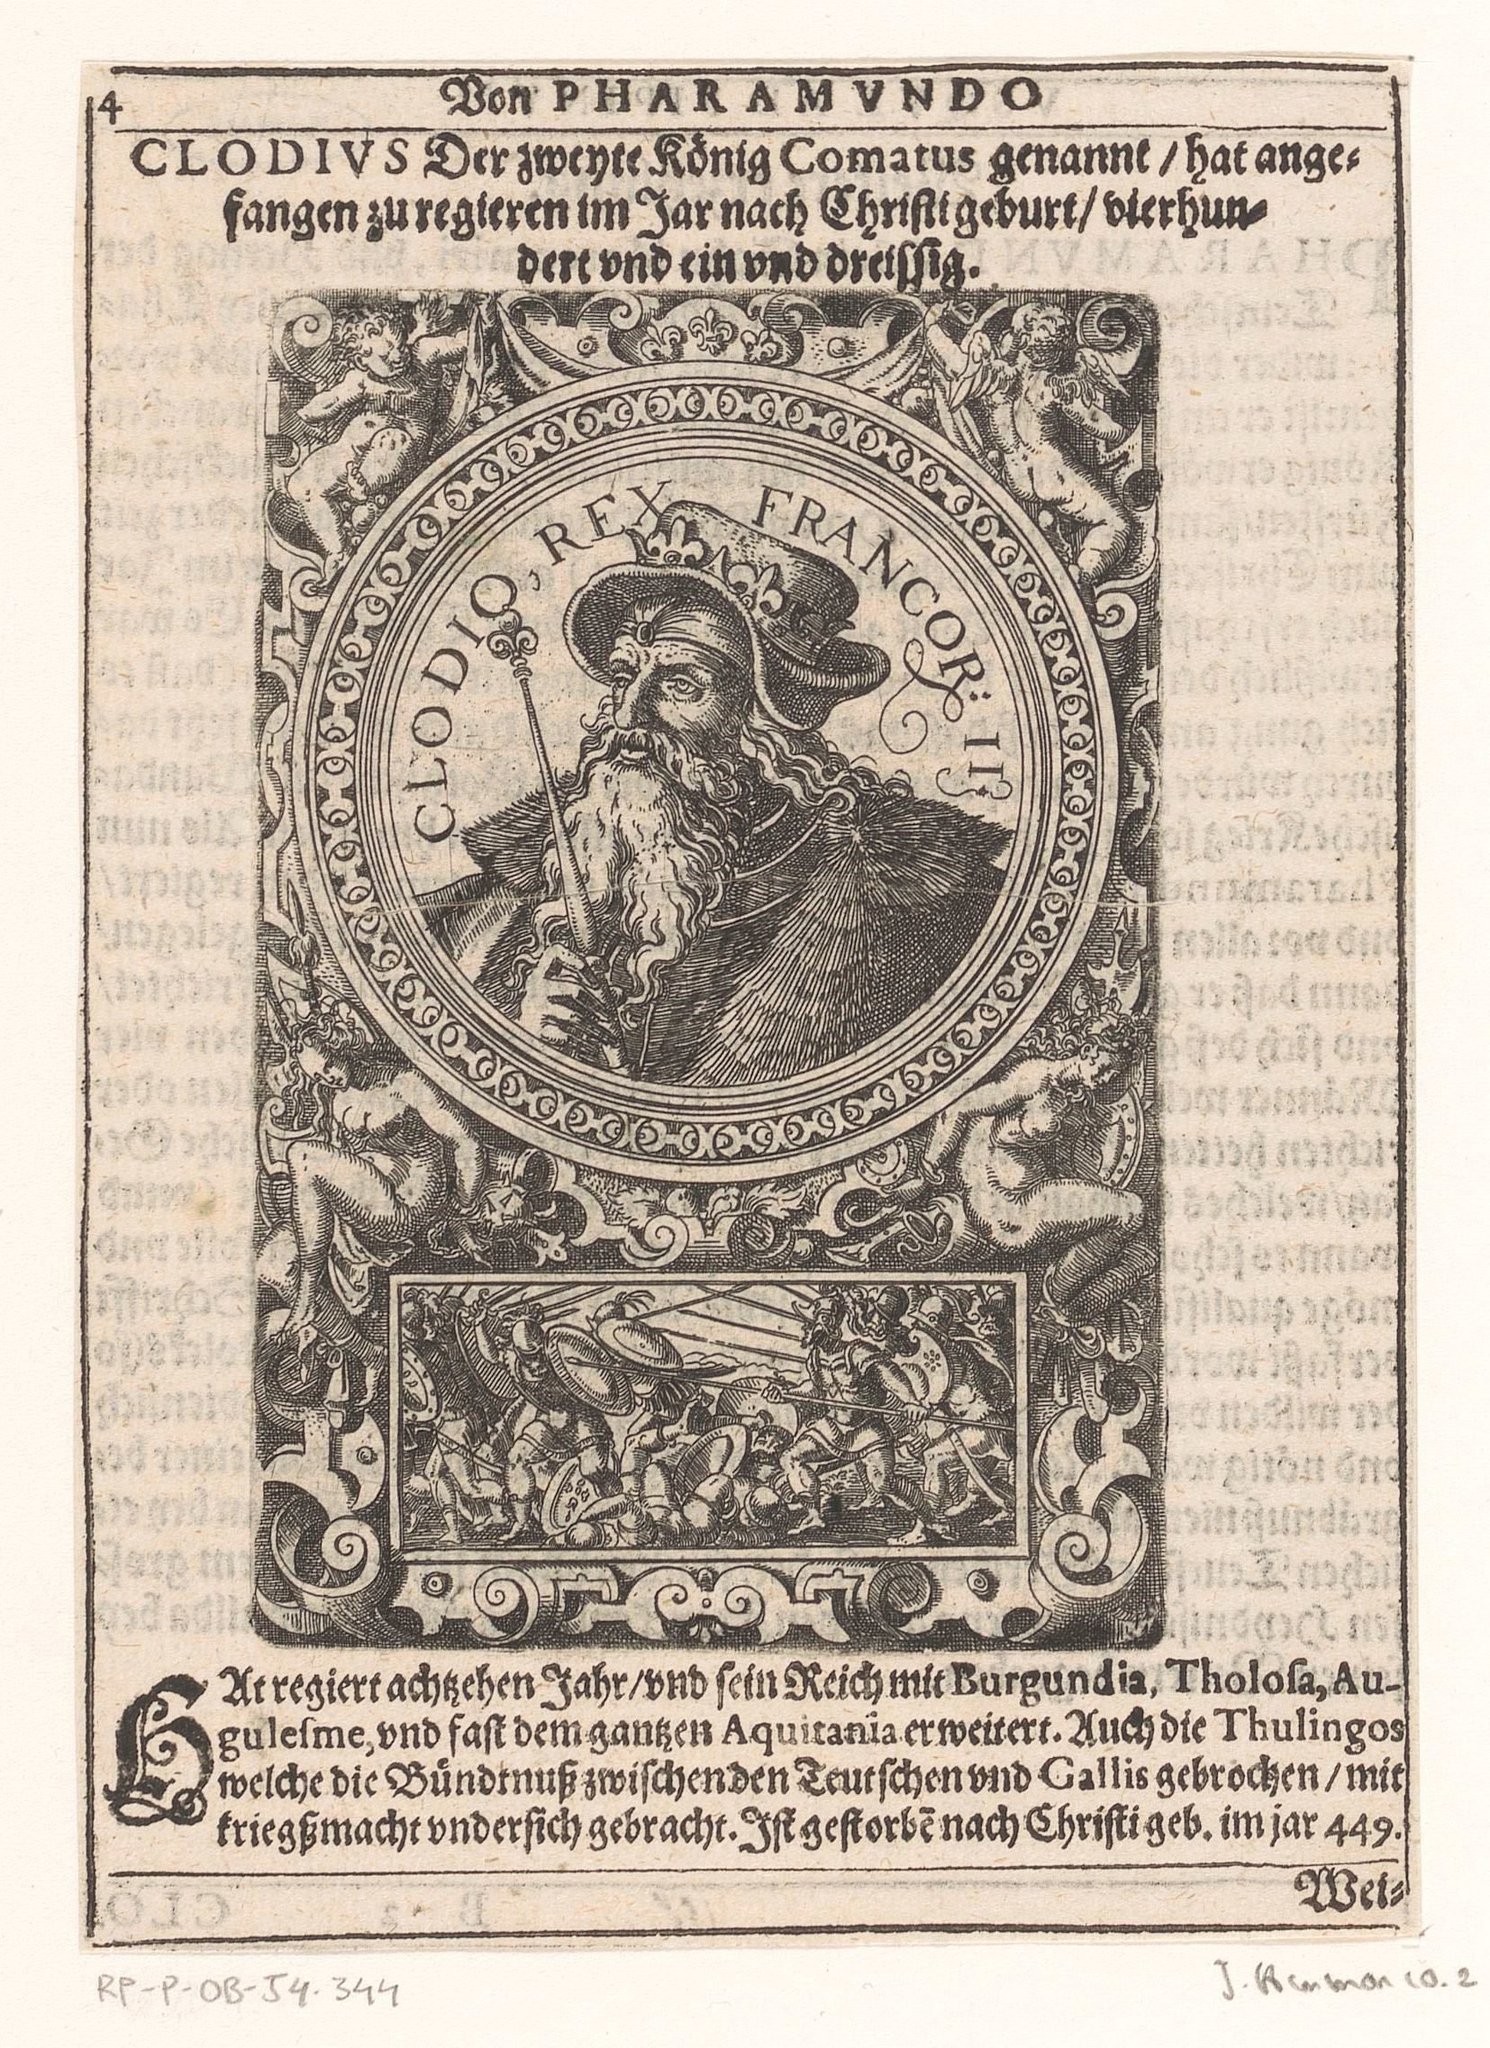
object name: print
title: Portret van Chlodio, koning der Franken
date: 1598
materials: paper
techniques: etching, intaglio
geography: nuremberg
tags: scrollwork, strapwork ~ ornament, historical persons, ruler, sovereign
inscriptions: number: ‘158’, collector's mark: Lugt 2228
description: Prent afkomstig uit de publicatie: Michael Eizinger. Könige in Frankreich. Keulen: Johann Bussemacher, 1598, p. 4. De publicatie bevat prenten van Jost Amman en Virgil Solis.